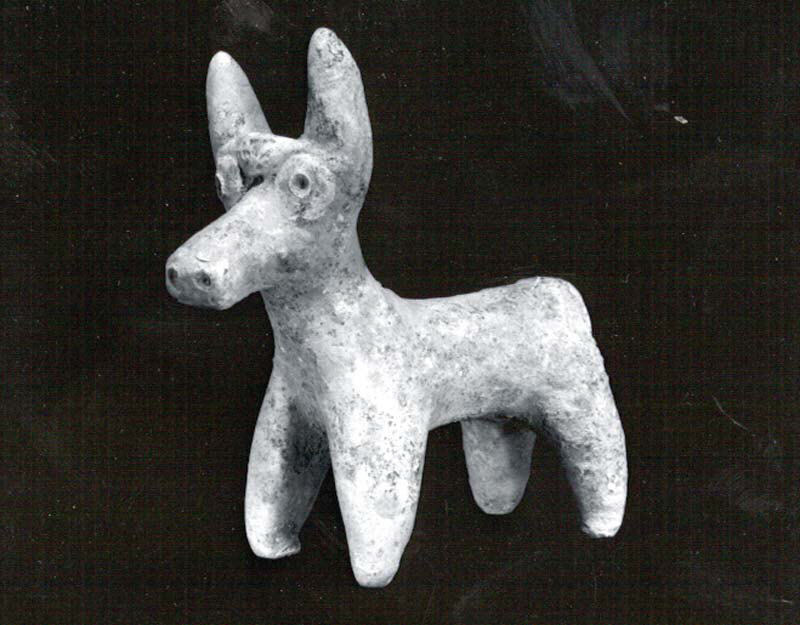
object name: sculpture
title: Figure of a bull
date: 1900-1750 BCE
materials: ceramic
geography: syria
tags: bulls